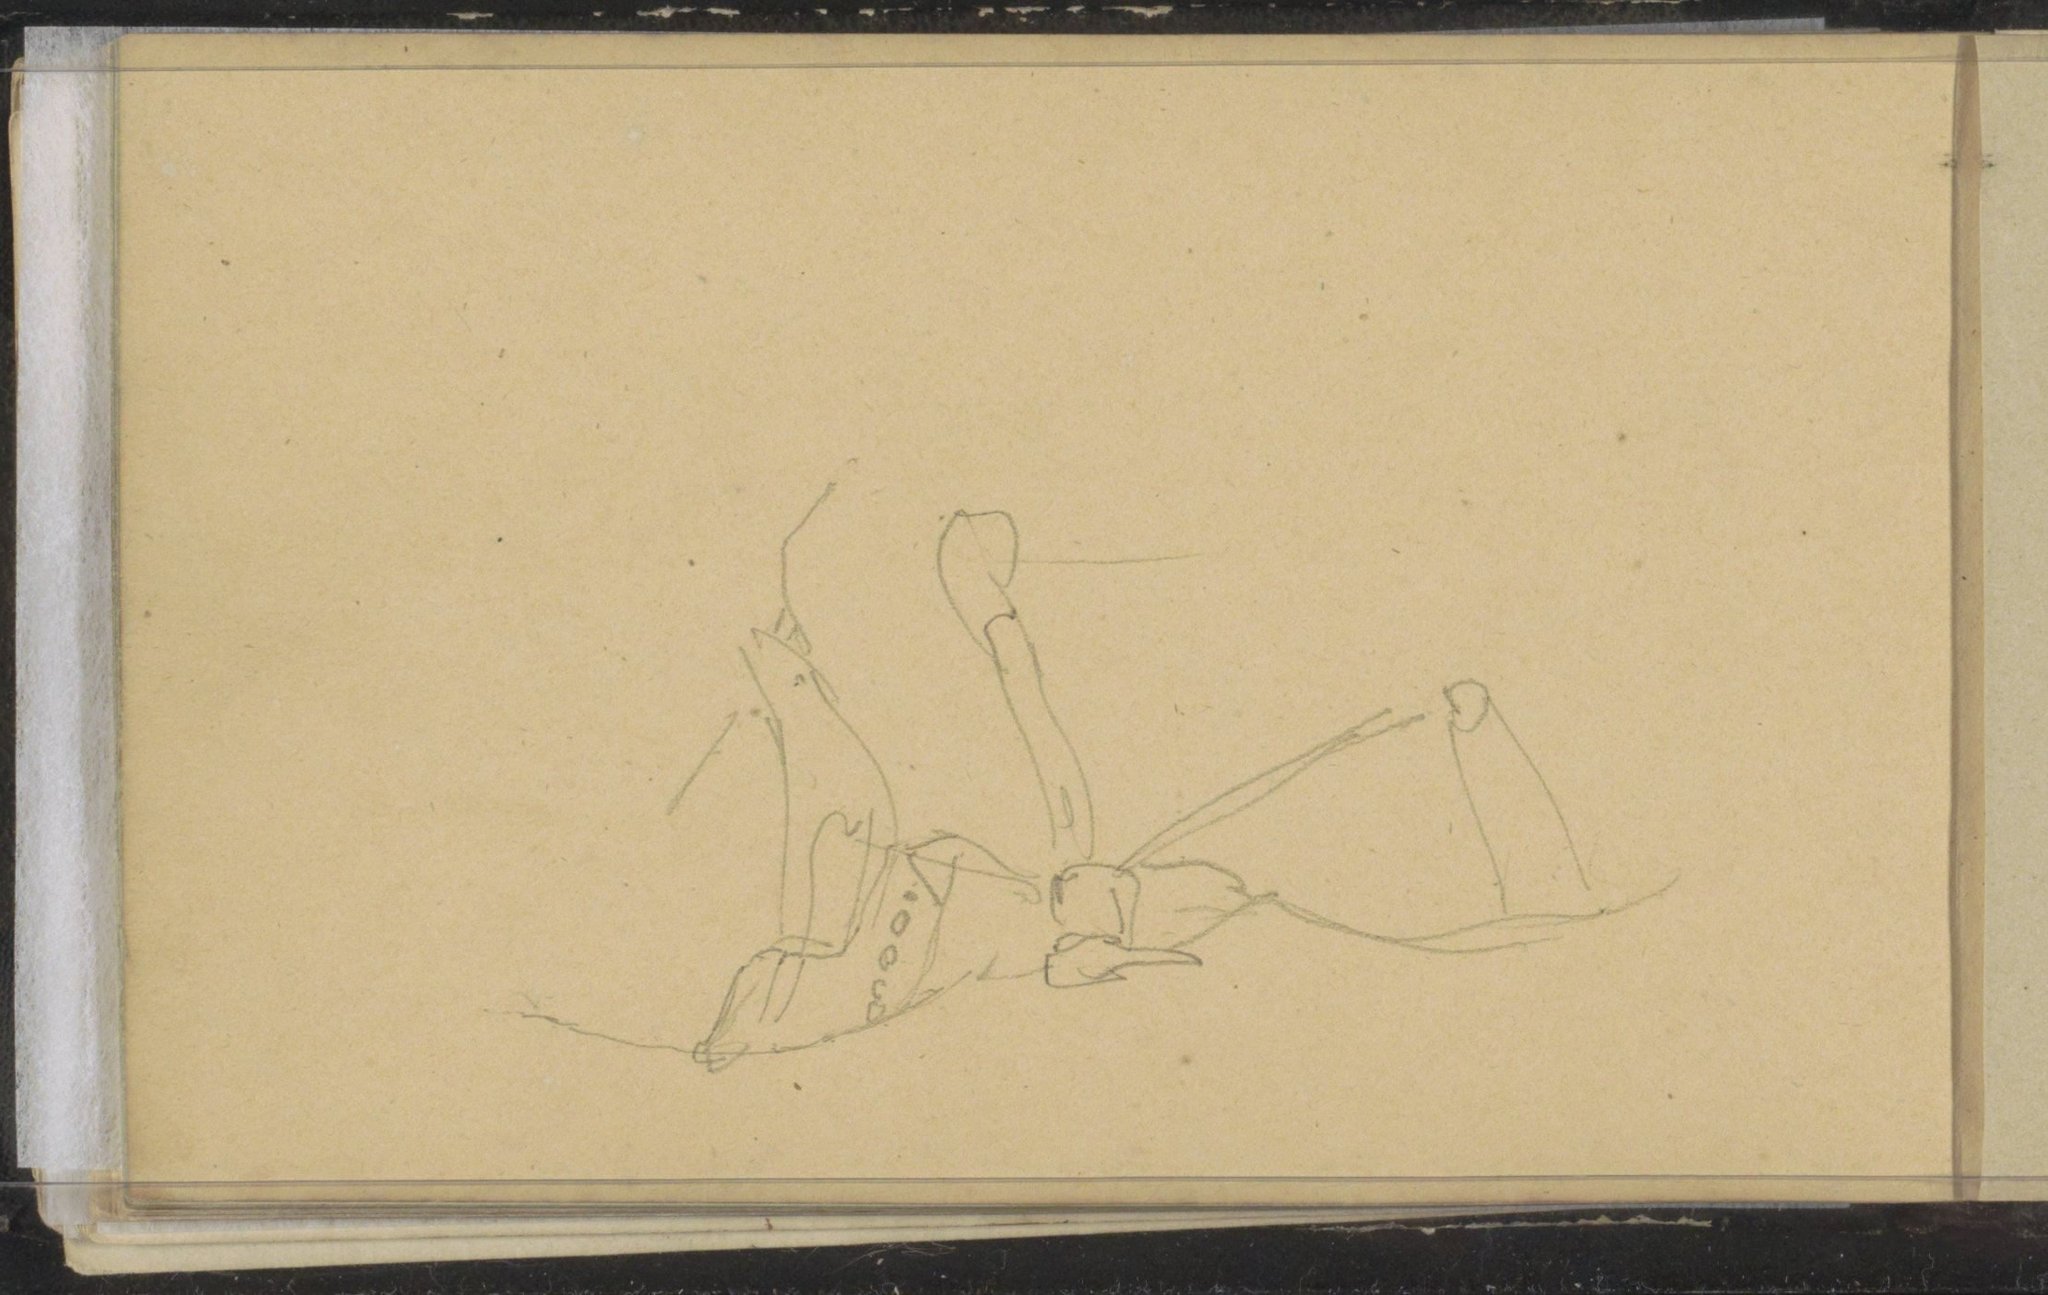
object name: sketchbook leaf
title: Paard met gareeltuig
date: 1863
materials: paper, pencil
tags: horse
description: Rug en nek van een paard met gareeltuig. Blad 46 verso uit een schetsboek met 55 bladen vervaardigd op de Veluwe en in Noord-Duitsland.